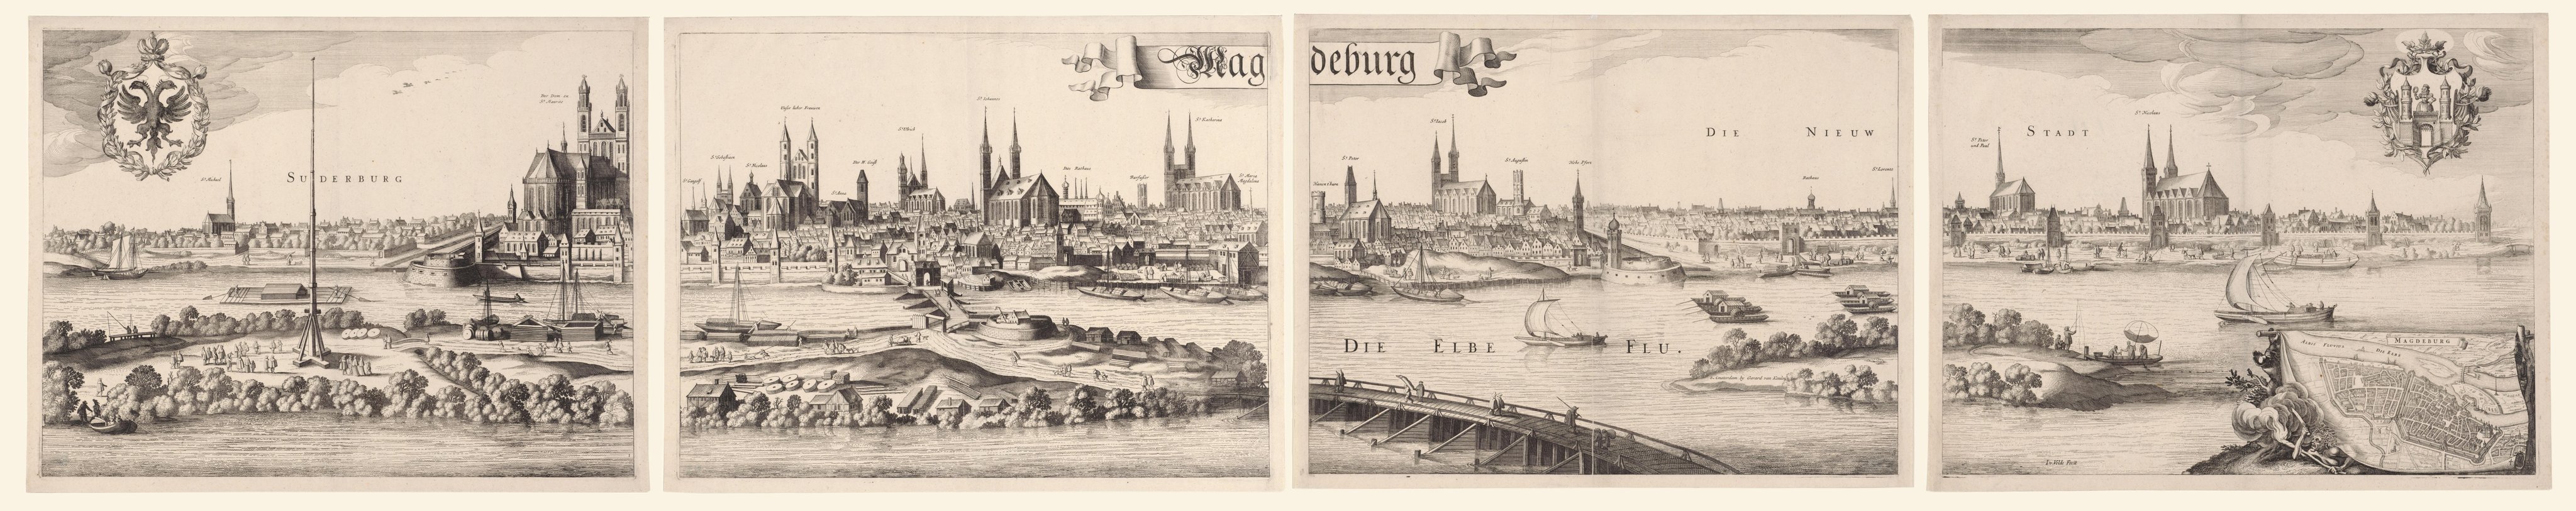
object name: print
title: Gezicht op Maagdenburg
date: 1637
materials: paper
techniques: etching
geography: amsterdam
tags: prospect of village, silhouette of village, shooting-the-bird (on a high pole)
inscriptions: collector's mark: Lugt 2165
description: Panorama van Maagdenburg, gezien van de overzijde van de Elbe naar het westen, met onder andere de Dom van Maagdenburg en de Sint-Johanneskerk. Linksboven het keizerlijke wapen van het Heilige Roomse Rijk en rechts het stadswapen van Maagdenburg. Links op de voorgrond een groep figuren bezig met vogelschieten, waarbij een schutter met zijn kruisboog een houten vogel van een paal tracht te schieten. Rechtsonder een stadsplattegrond van Maagdenburg.